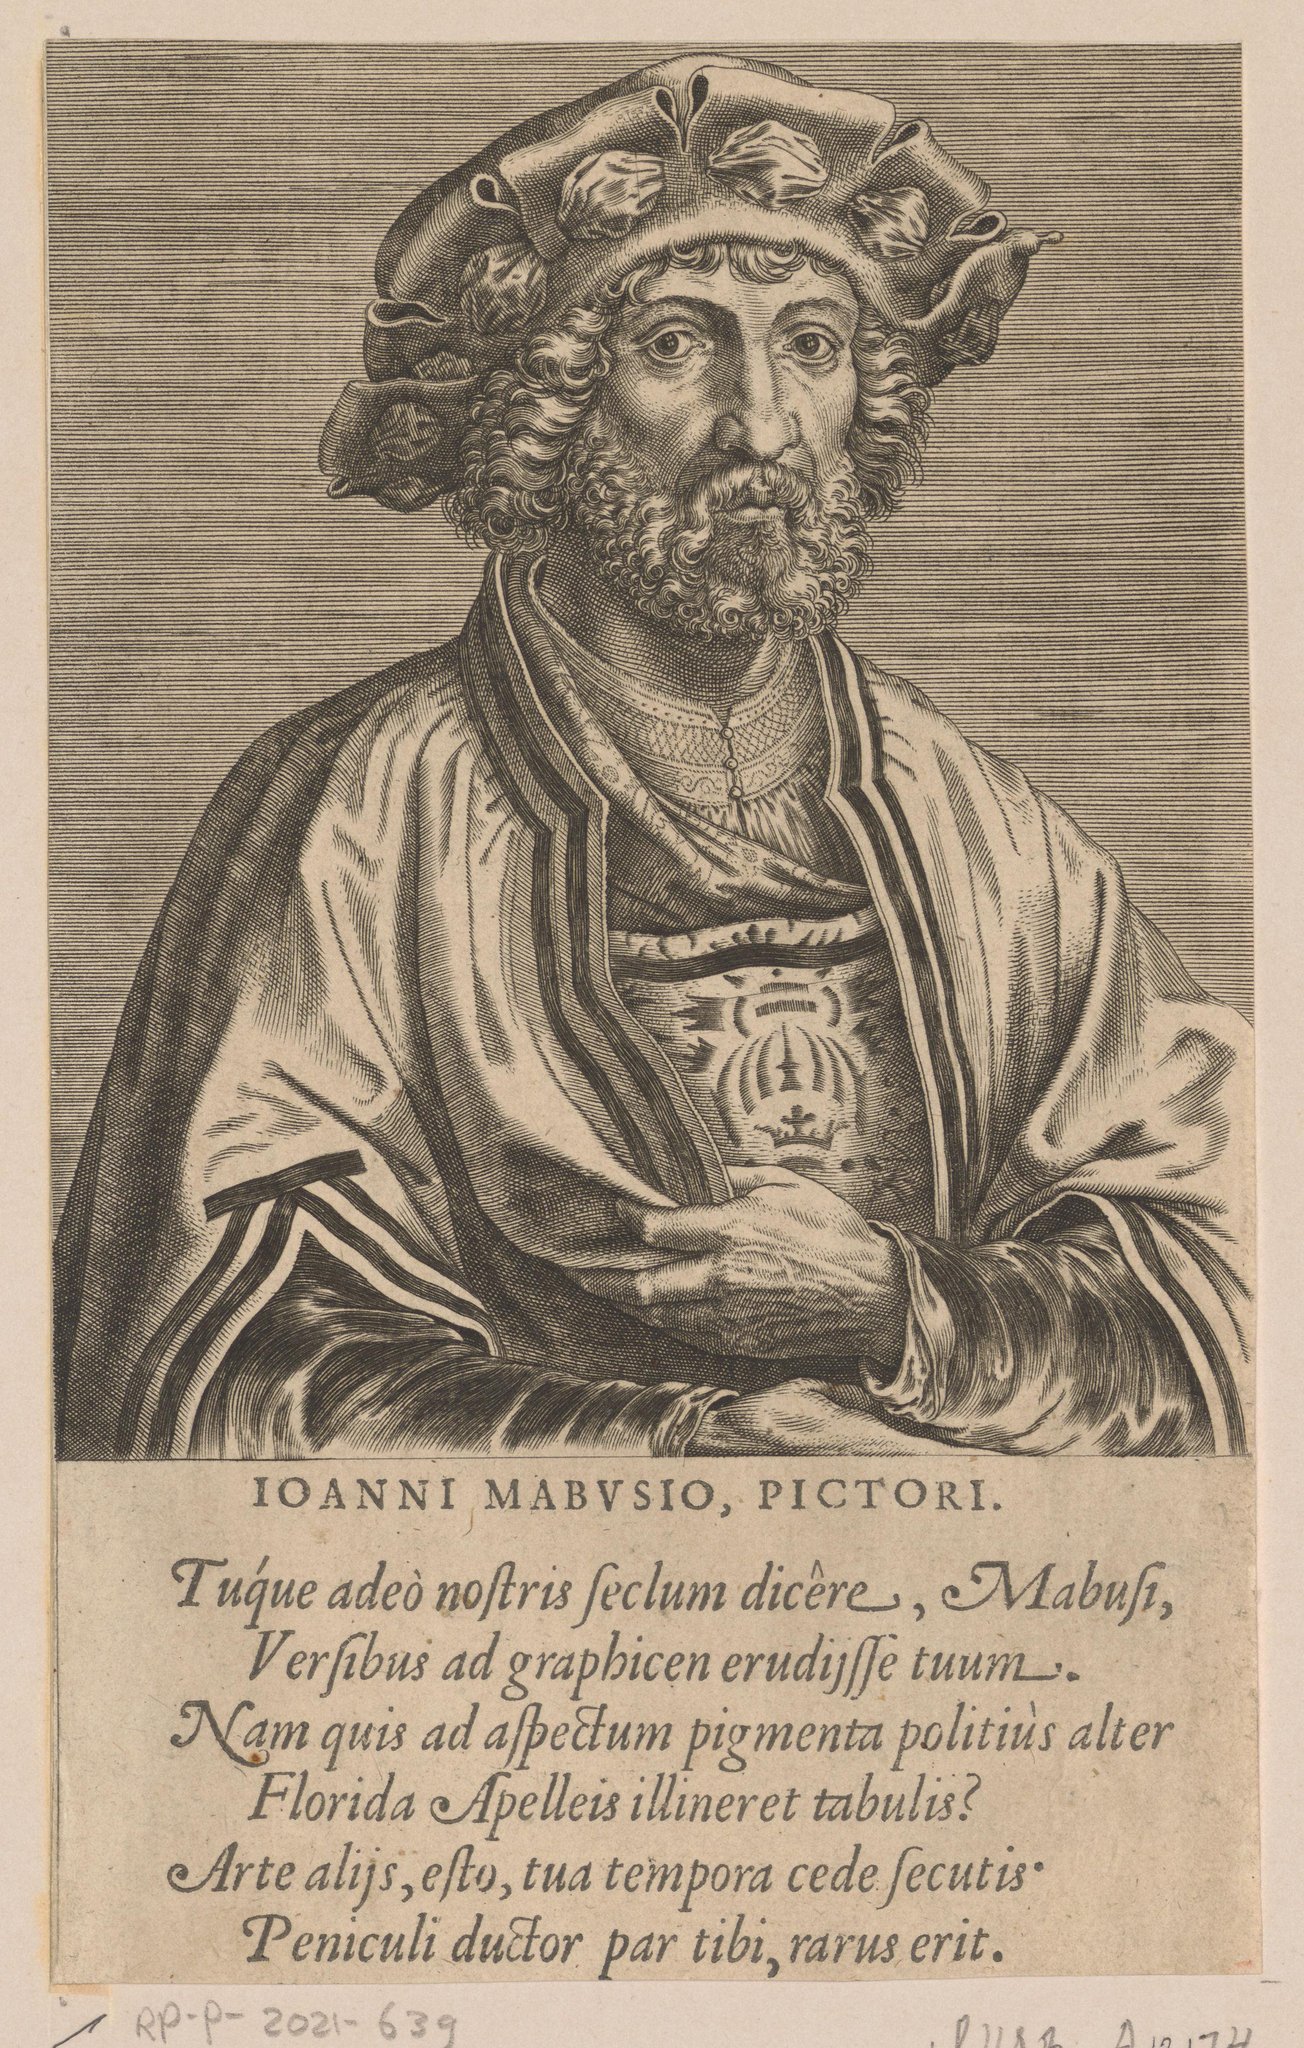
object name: print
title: Portret van Jan Gossaert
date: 1572-1633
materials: paper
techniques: engraving, etching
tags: antwerp, painter, print maker, draughtsman, jan gossart, historical persons, portrait, self-portrait of painter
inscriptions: collector's mark: Lugt 2165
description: Prent mogelijk gebruikt in: Hondius, Hendrick en Dominicus Lampsonius. Theatrum Honoris in quo nostri apelles, saeculi seu Pictorum qui patrum nostrorum memoria vixerunt celebriorum. Amsterdam: Johann Lampsonius, [1610-1618]. Prent maakt mogelijk deel uit van de series 'Illustrium Quos Belgium Habuit Pictorum Effigies. Antwerpiae' uitgegeven door Theodoor Galle in 1600, en 'Pictorum Aliquot Celebrium Germaniae Inferioris Effigies' uitgegeven door Hendrick (I) Hondius in 1610.